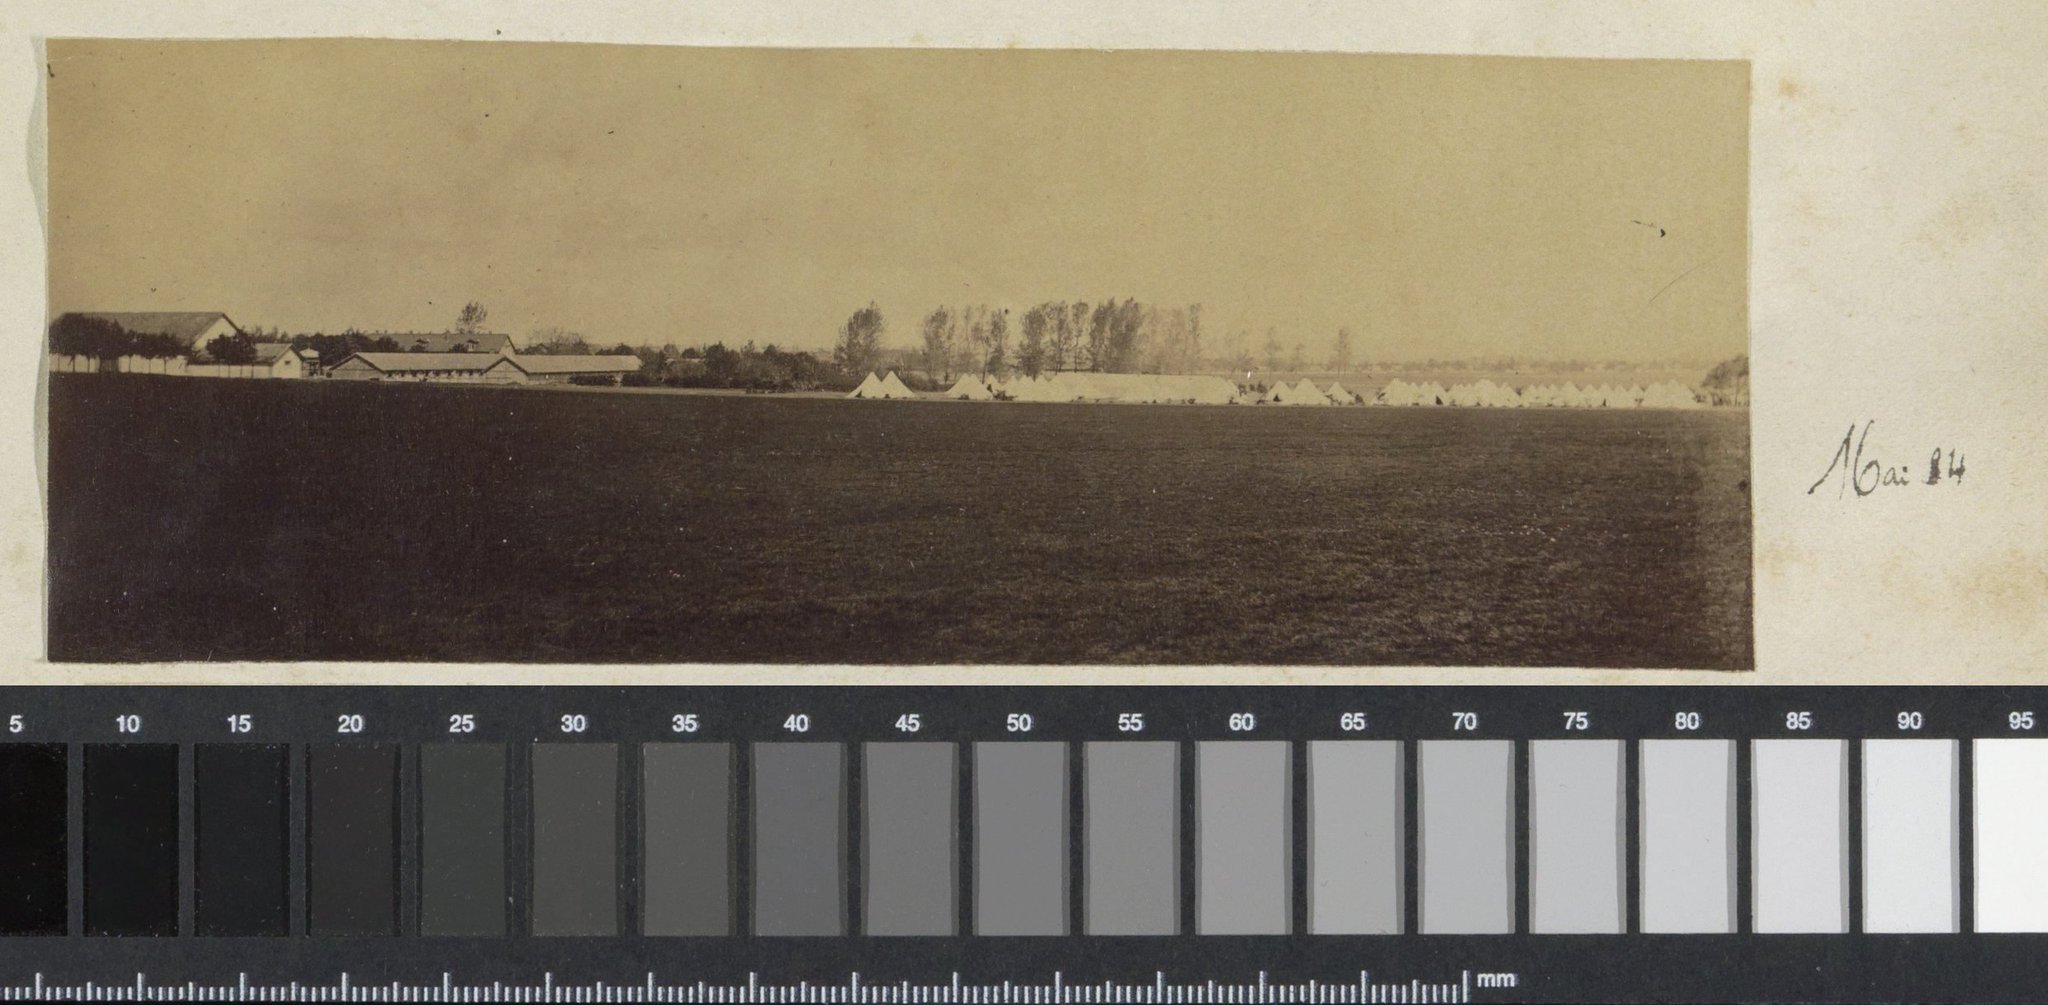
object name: photograph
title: Gezicht op een militair tentenkamp in Frankrijk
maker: Anonymous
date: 1805-1884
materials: photographic support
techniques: albumen print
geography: france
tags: (military) camp with tents, france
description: Onderdeel van Album van een Franse amateurfotograaf met opnames van familie, militairen, industrie, landschappen en bezienswaardigheden in Frankrijk.